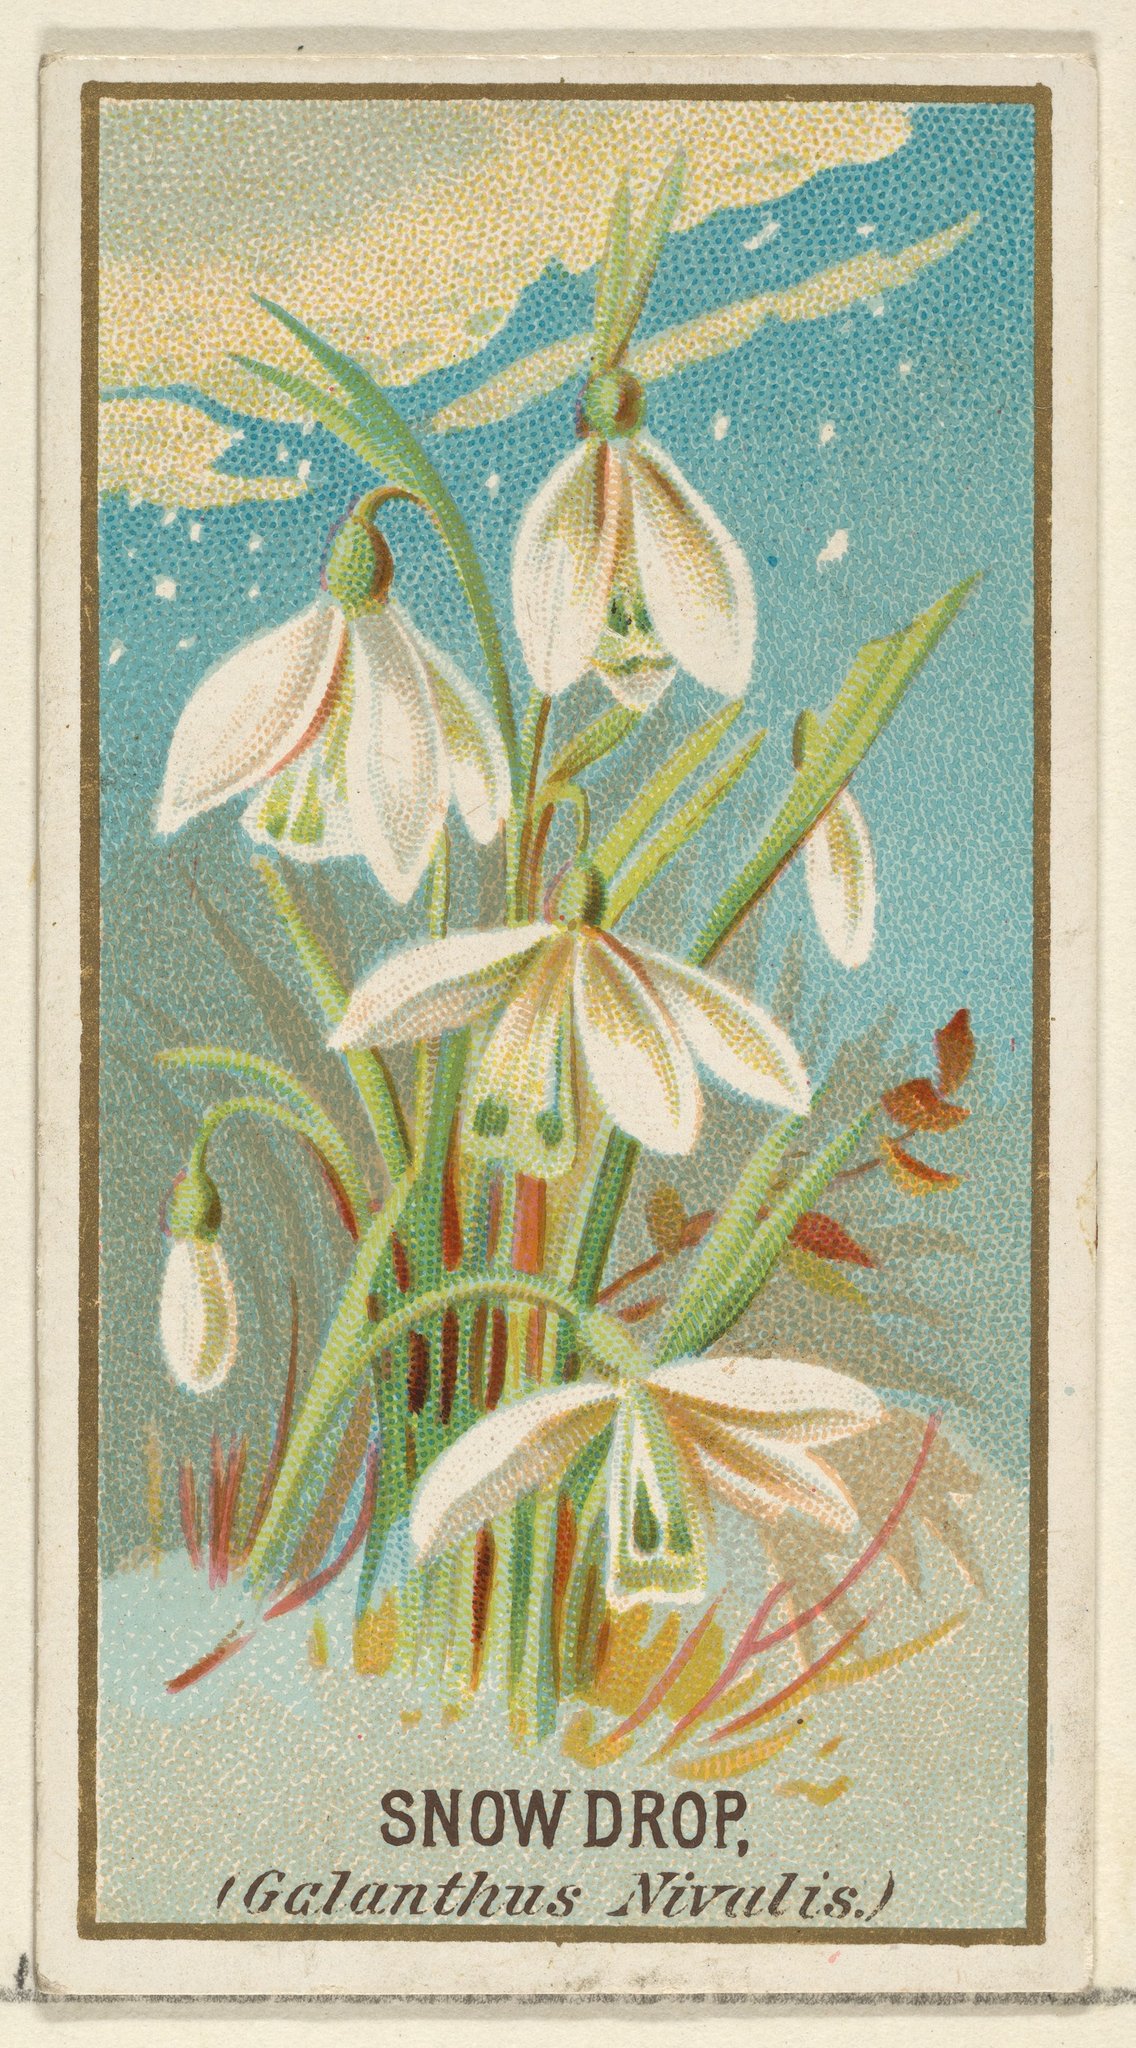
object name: print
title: Snowdrop (Galanthus Nivalis), from the Flowers series for Old Judge Cigarettes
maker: goodwin & company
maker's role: publisher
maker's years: 1850-1950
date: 1890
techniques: color lithograph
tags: flowers